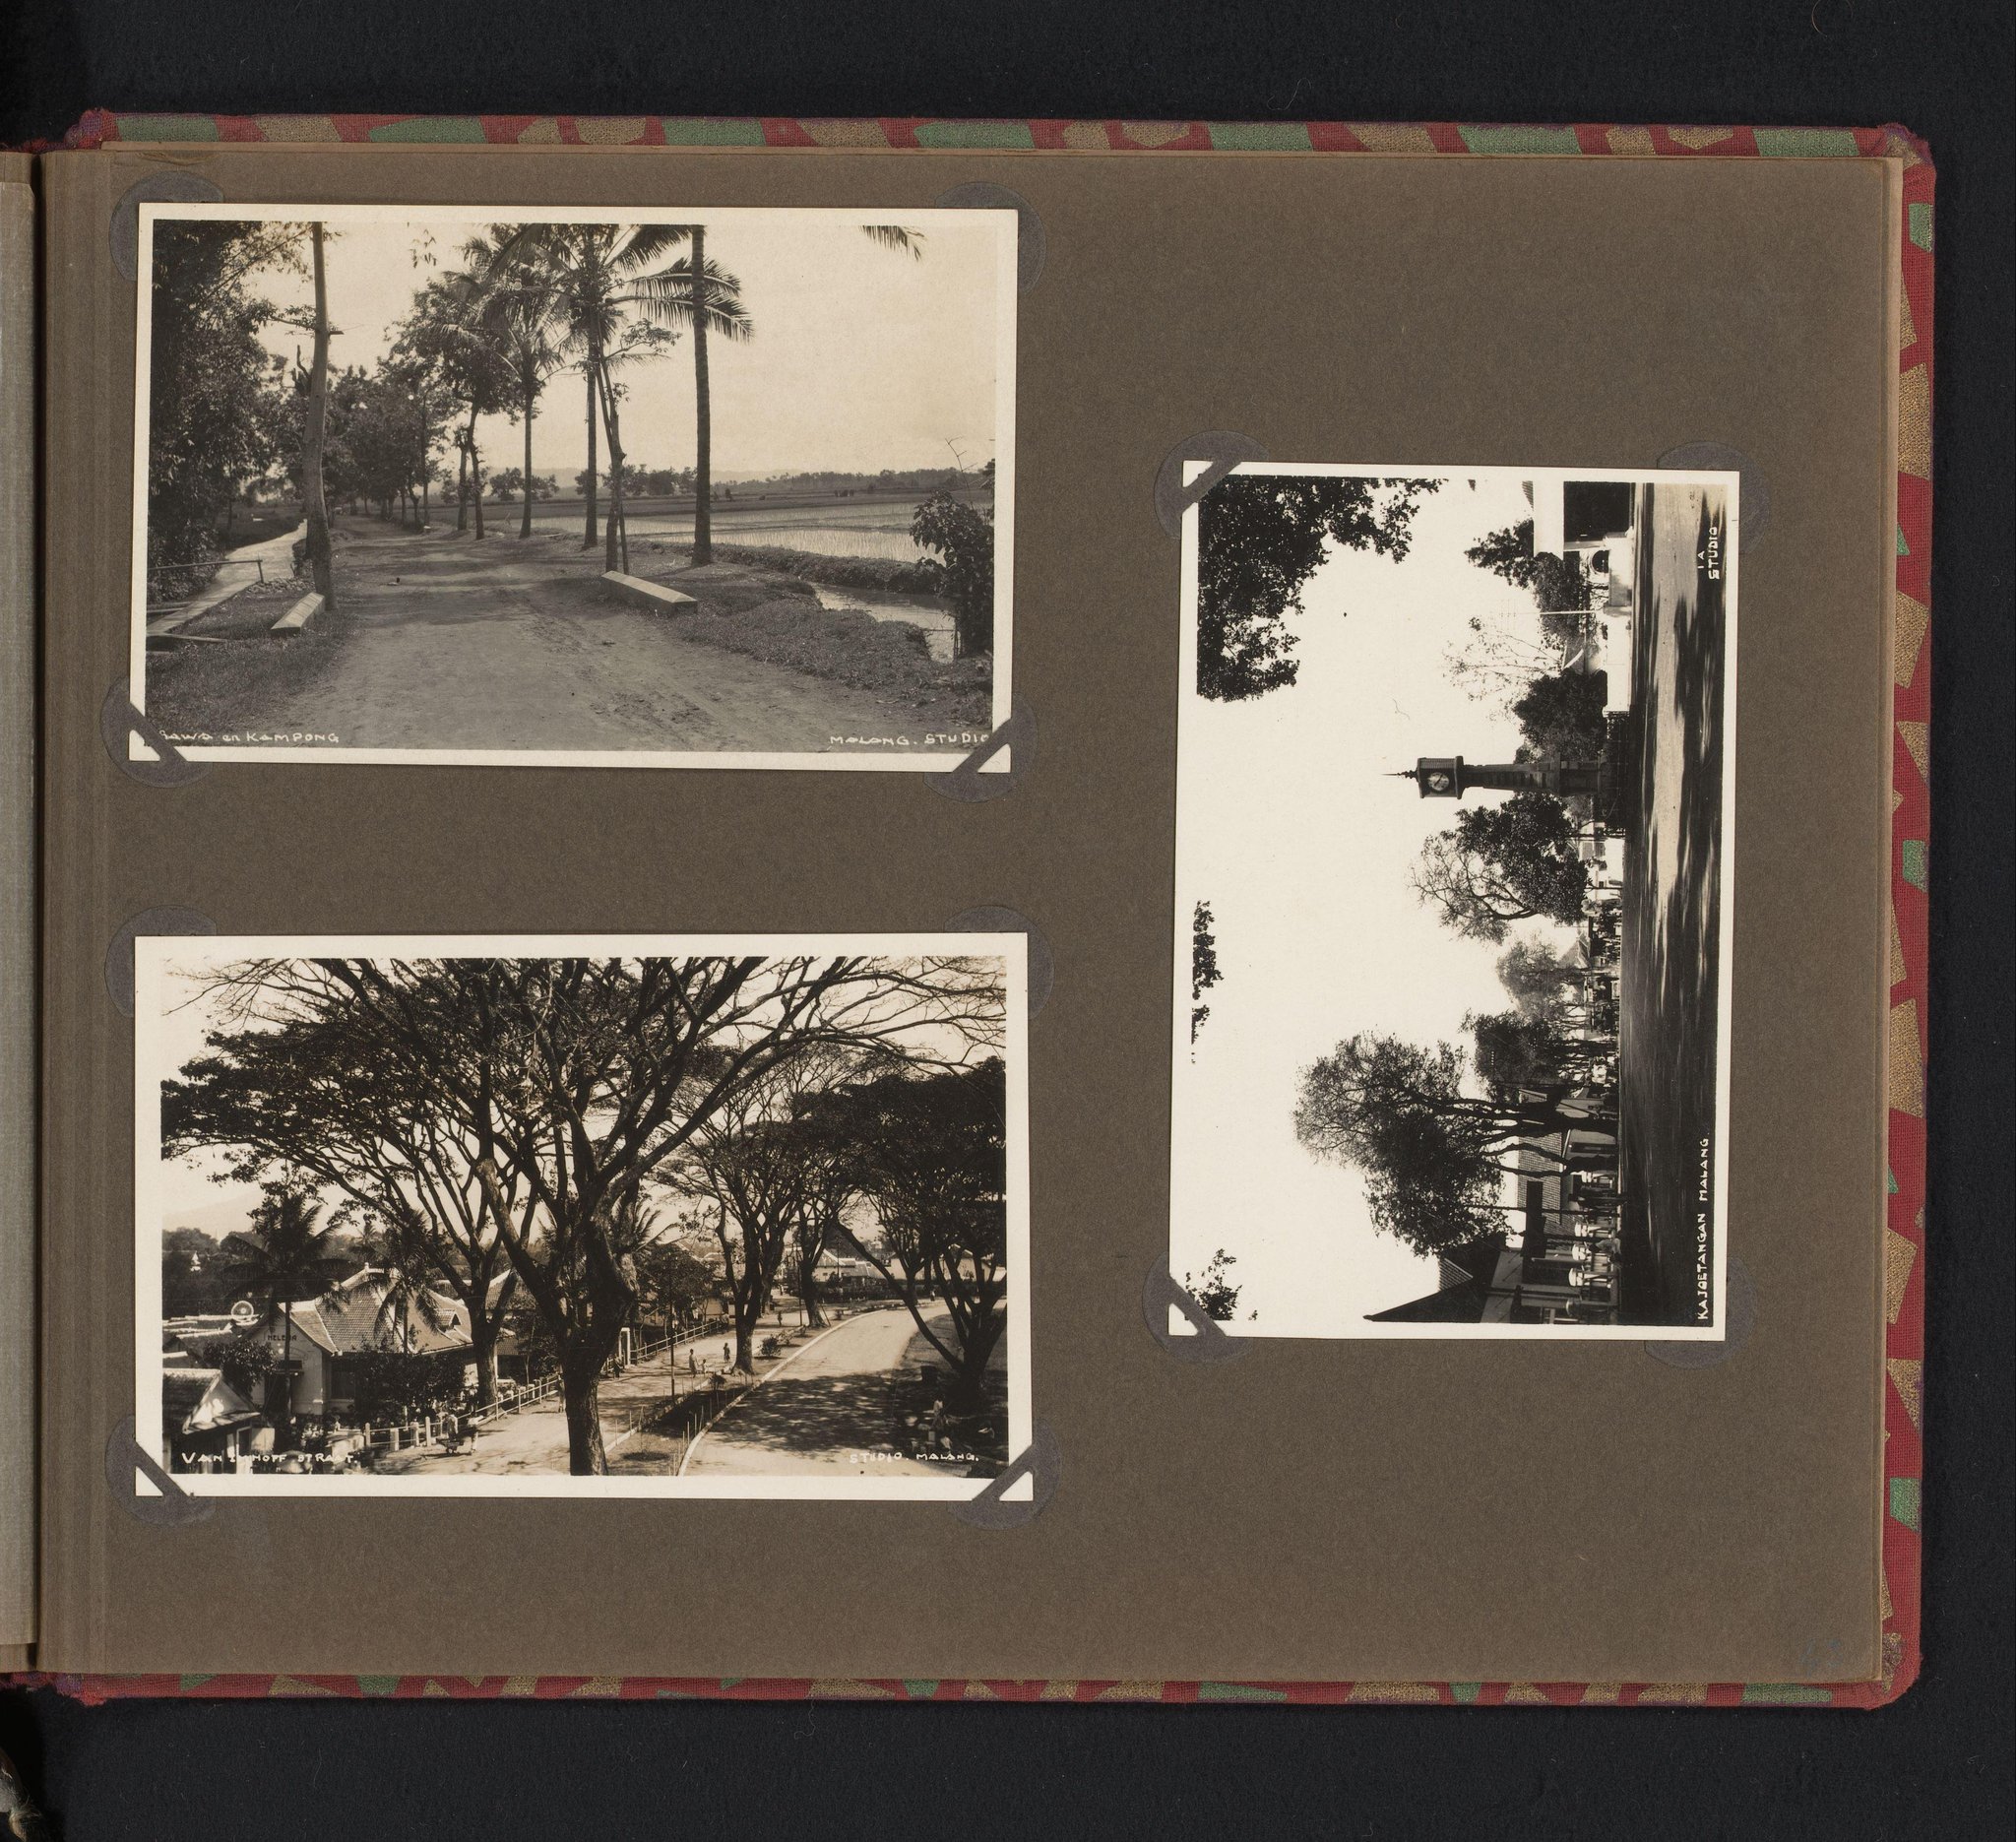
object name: album leaf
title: Gezichten te Malang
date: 1920-1933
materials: cardboard, photographic support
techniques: gelatin silver print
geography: malang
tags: douwe de vries, landscapes in tropical and sub-tropical regions, public road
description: Blad met drie prentbriefkaarten met gezichten te Malang. Onderdeel van het fotoalbum (4) van KNIL-sergeant D. de Vries, 1925-1933.